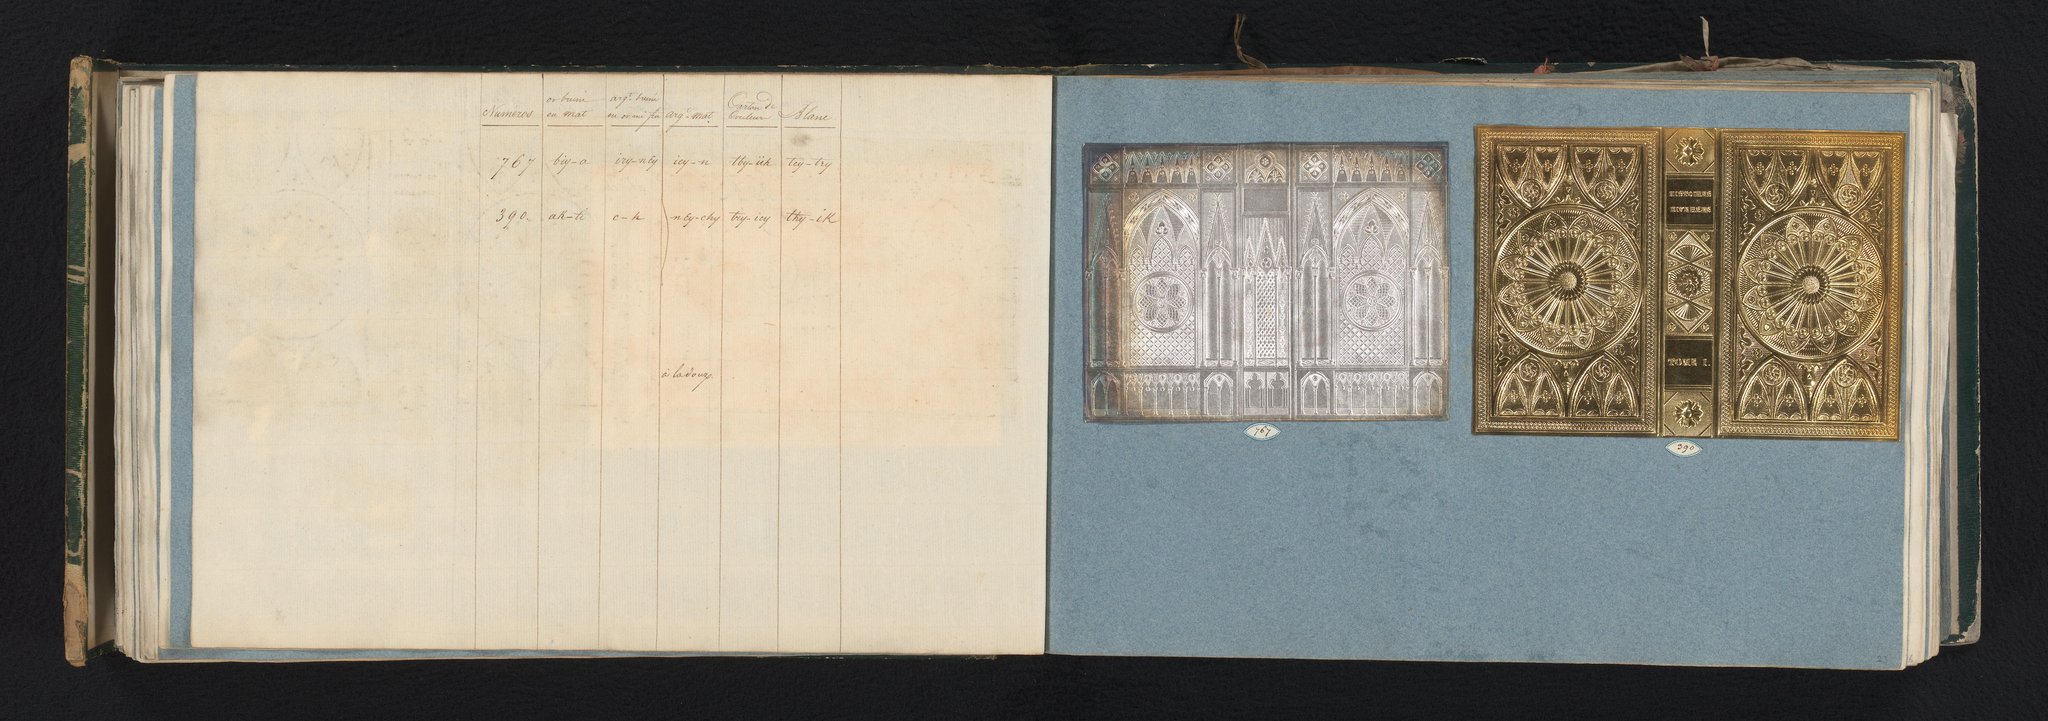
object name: sample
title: Twee bladzijden met stalen van vignetten van goud- en zilverkleurig metaalpapier en bijbehorend tabel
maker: Anonymous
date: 1830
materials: gold leaf, ink, paper, silver leaf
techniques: manufacturing, writing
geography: france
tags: ornaments ~ art, interior of church, book-cover, binding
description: Twee bladzijden met rechts 2 opgeplakte en met etiketten genummerde (767 en 390) stalen van ornamenten van goud- en zilverkleurig metaalpapier. In de vorm van kerkarchitectuur en een boekband. Op de tegenoverliggende linkerbladzijde een tabel met de handgeschreven corresponderende specificaties (in code) per ornament. Onderdeel van het stalenboek geschonken door de dames Van Rijn, vermoedelijk van een Franse papierfabrikant van luxe papieren, of diens vertegenwoordiger in Nederland, ca. 1830.